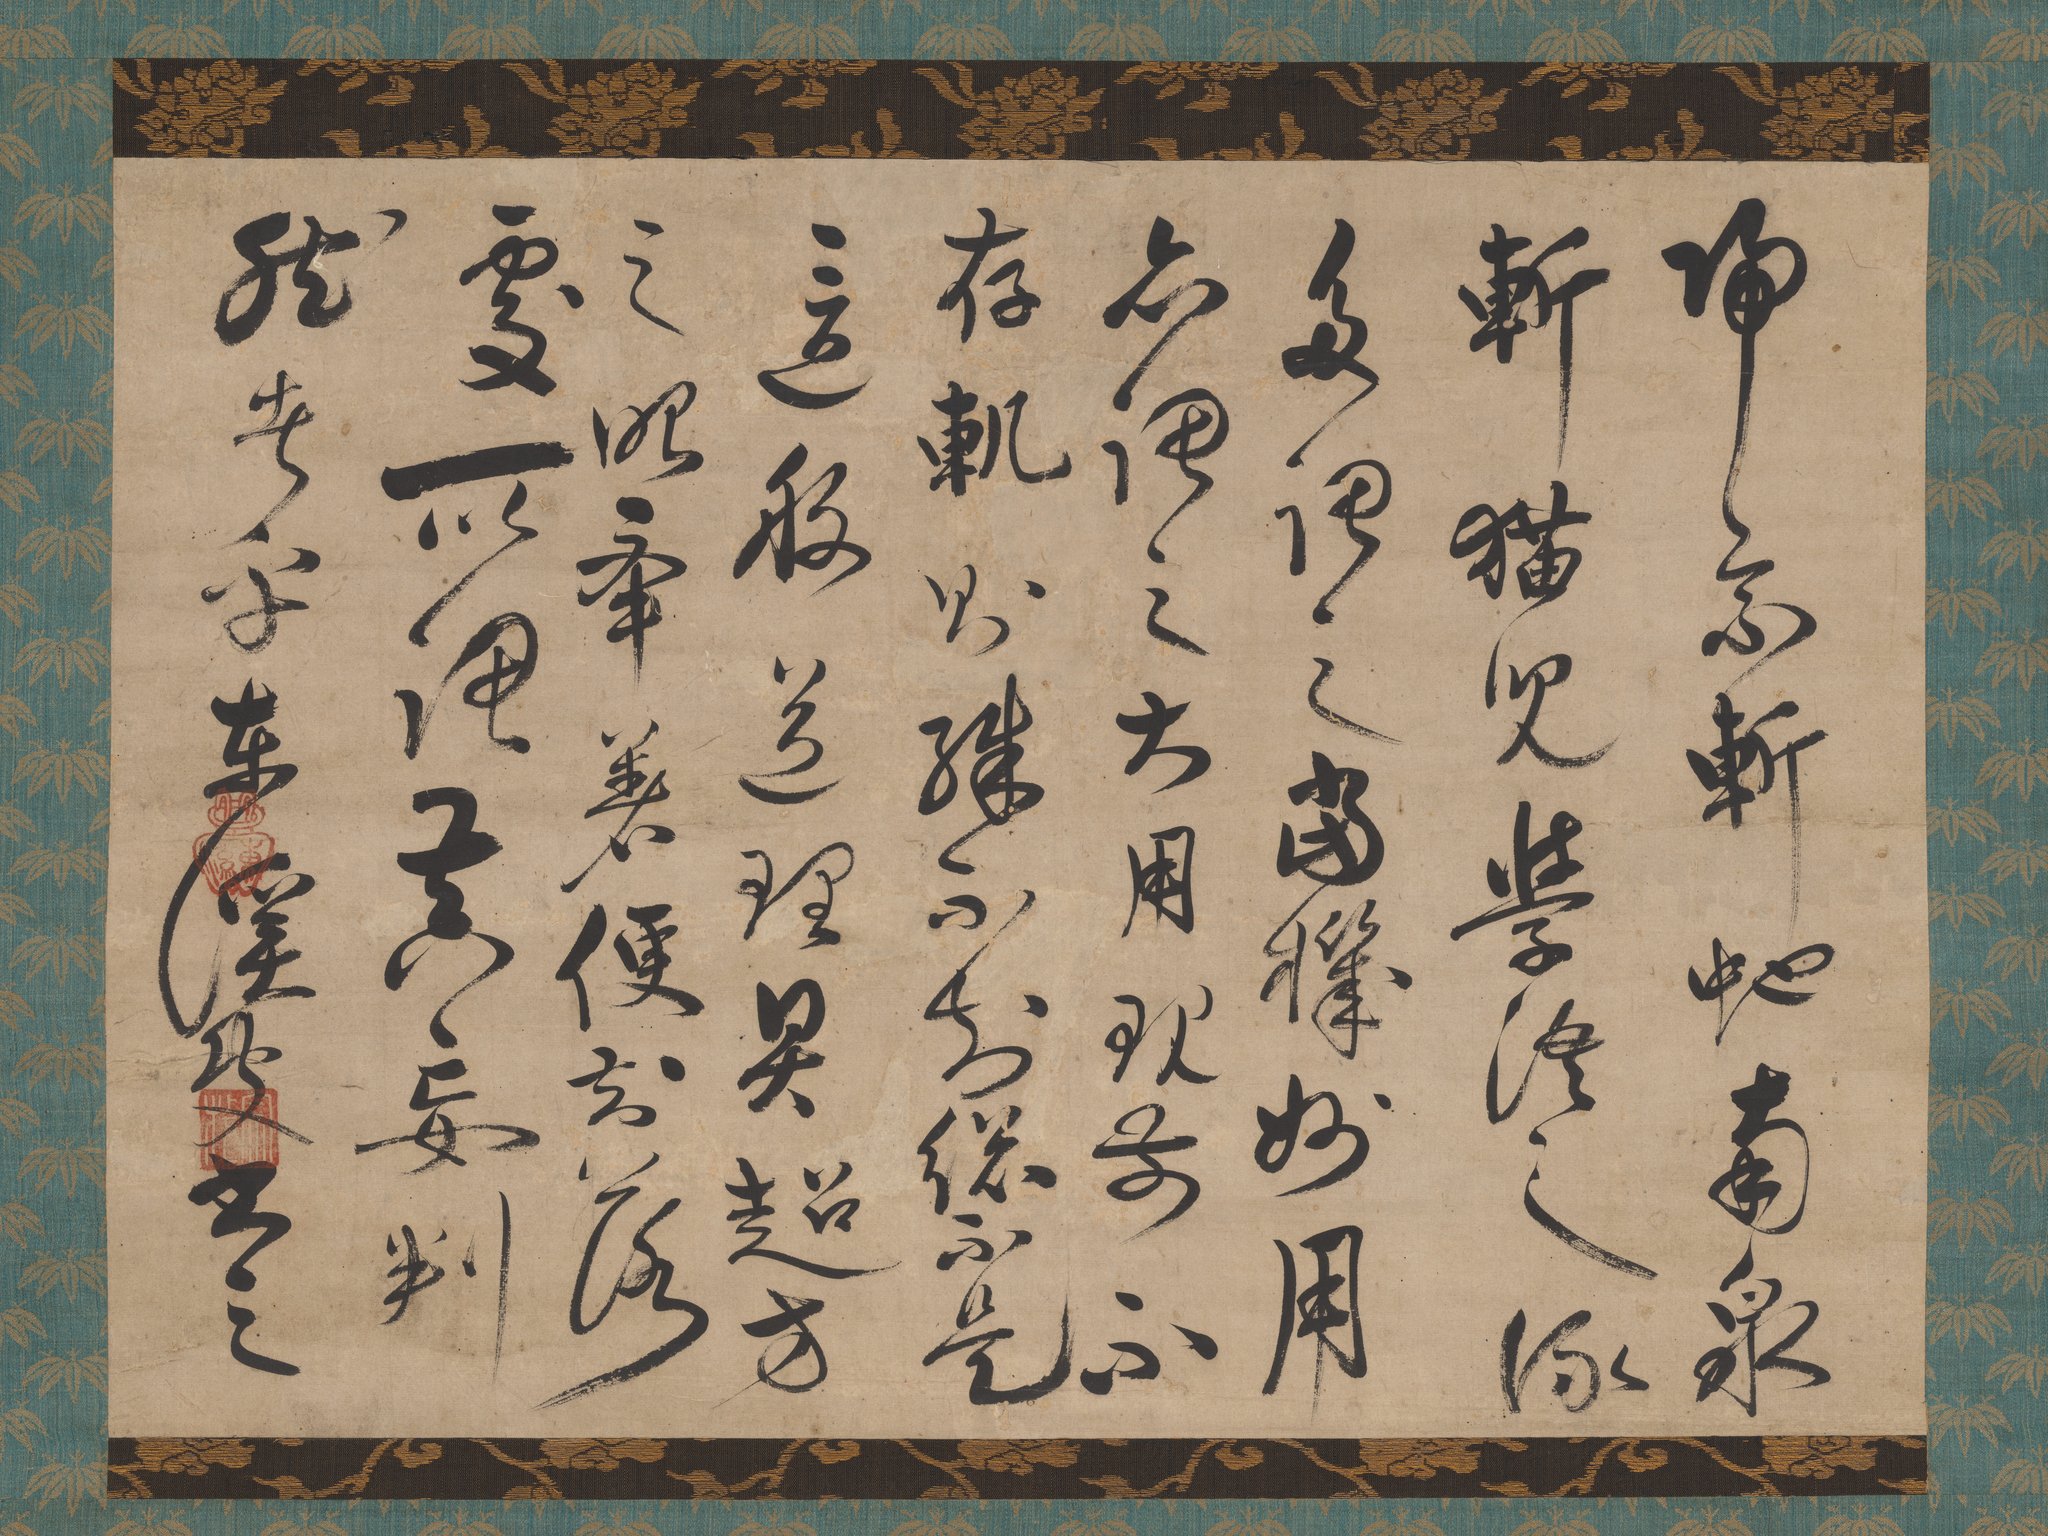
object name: hanging scroll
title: Critiquing the Reliance on Koans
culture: japanese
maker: tōkei sōboku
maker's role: artist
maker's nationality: japanese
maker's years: 1454-1517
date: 1467-1533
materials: ink, paper